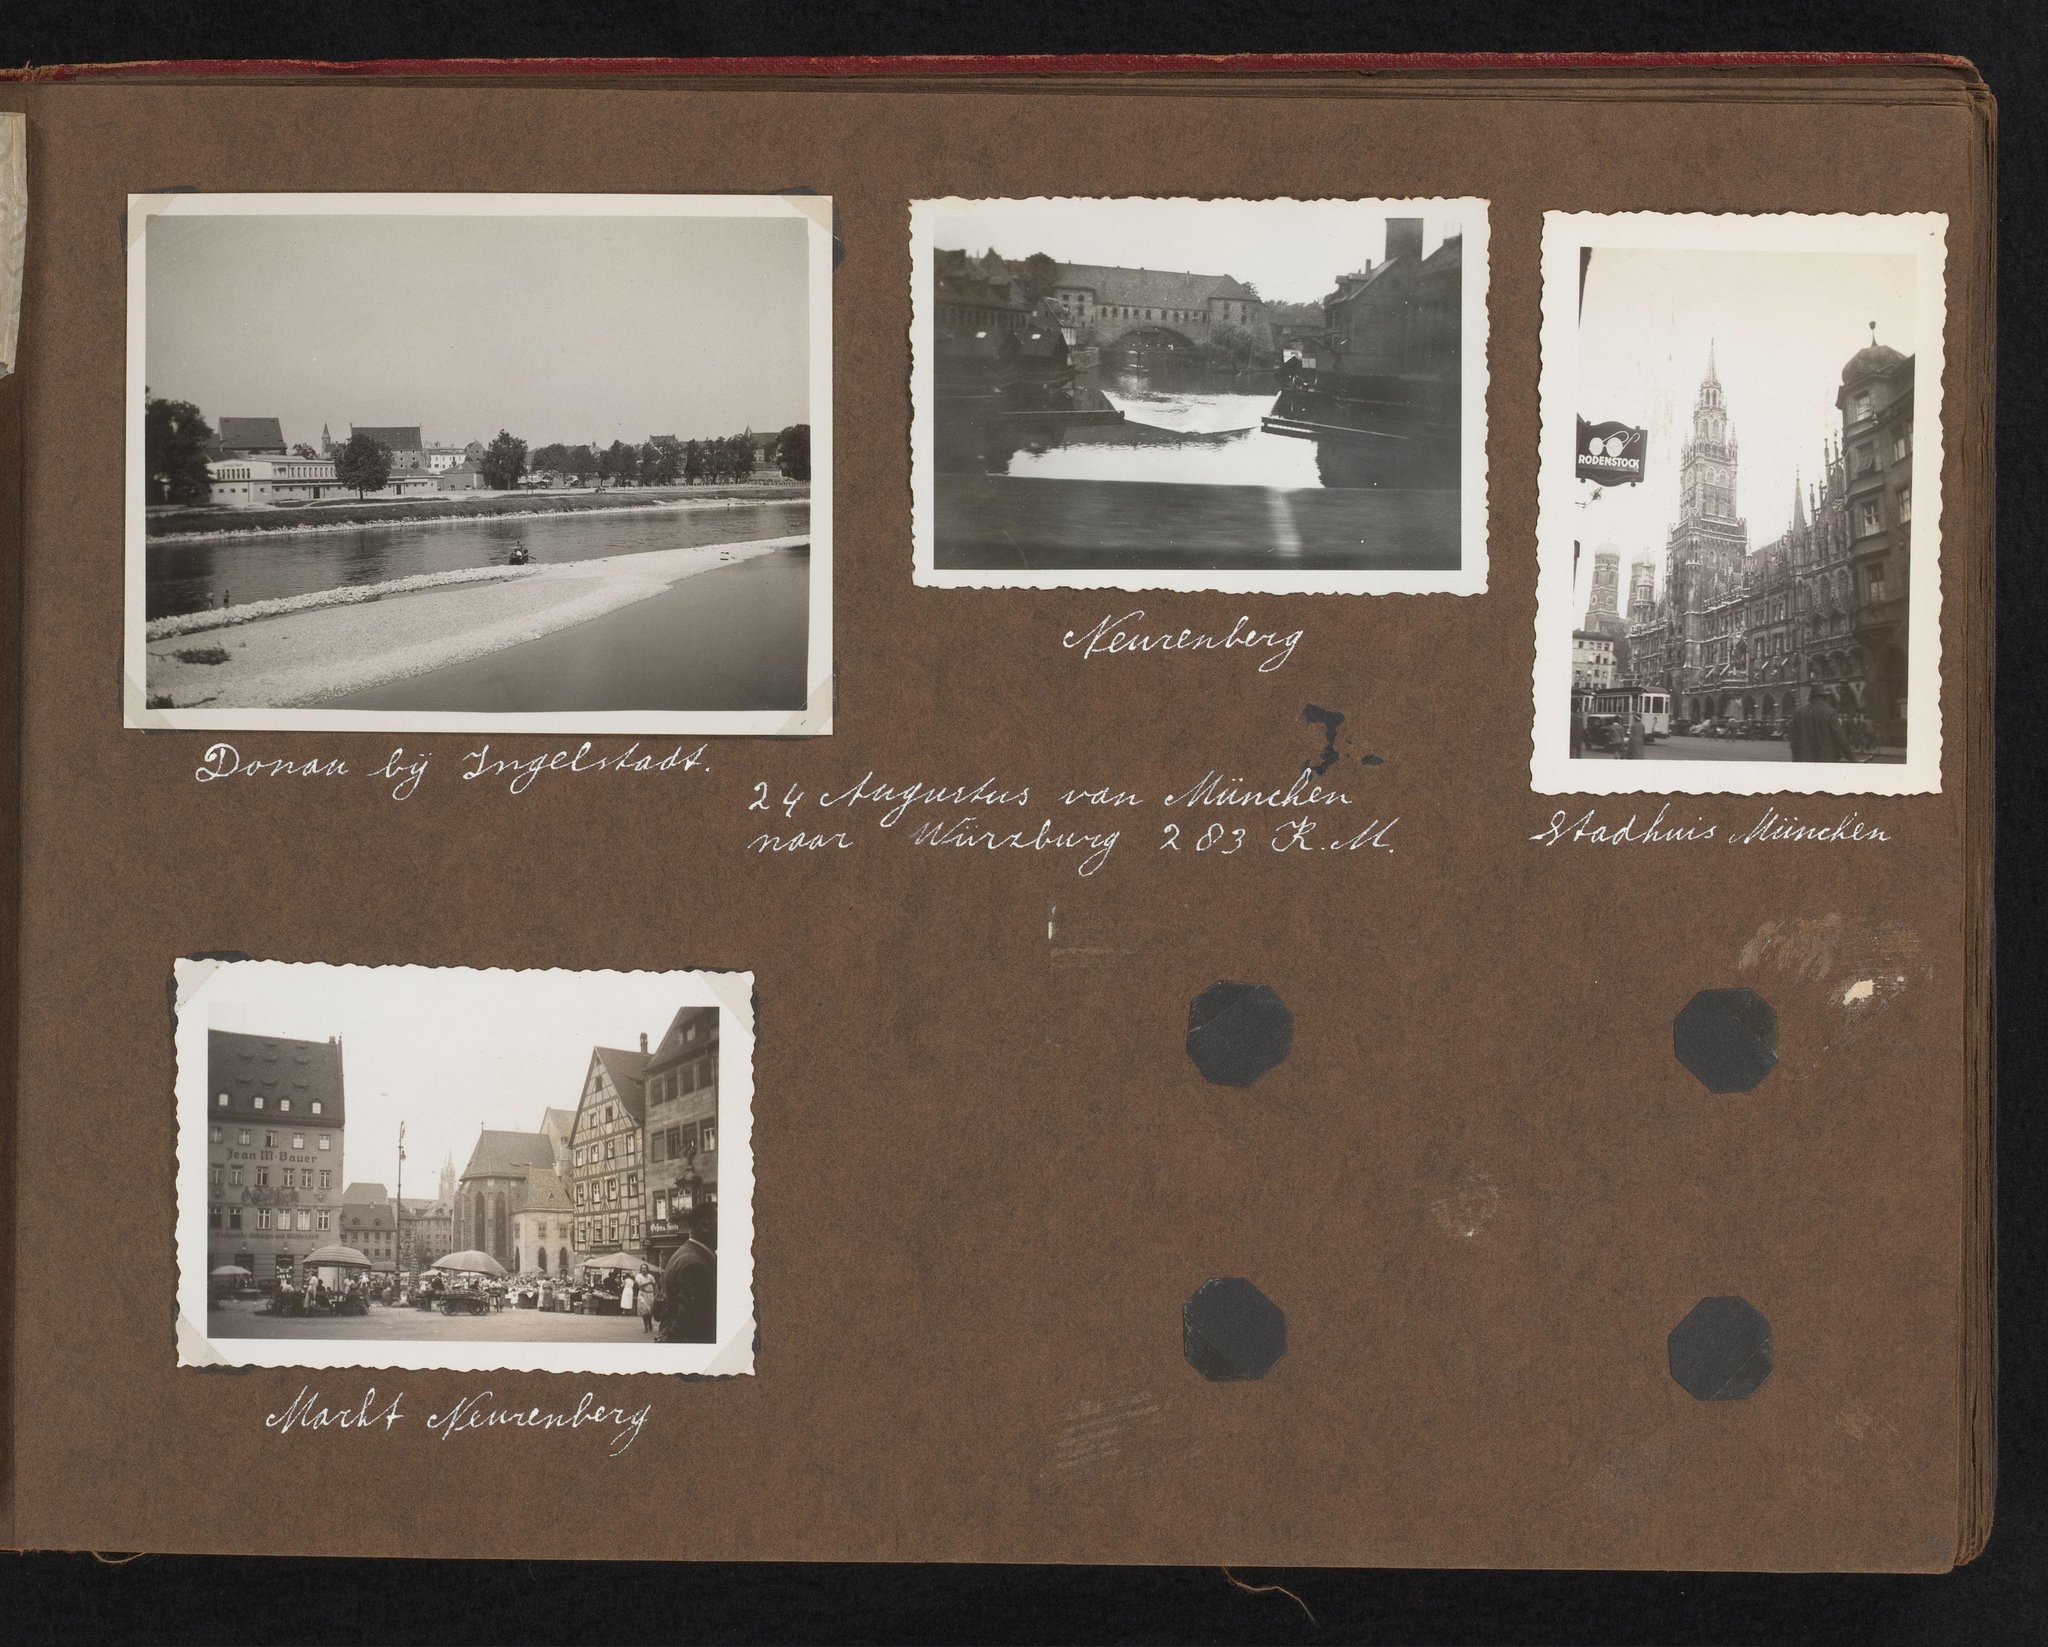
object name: album leaf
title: 24 Augustus van München naar Würzburg 283 K.M.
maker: Anonymous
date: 1908-1935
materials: paper, photographic support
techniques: gelatin silver print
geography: germany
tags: city-view in general; 'veduta', outing, pleasure trip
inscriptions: inscription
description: Albumblad met vier foto's met gezichten te München, Ingolstadt en Neurenberg, 24 augustus 1935. Onderdeel van het reisalbum van de familie Van den Broek 1935-1937.